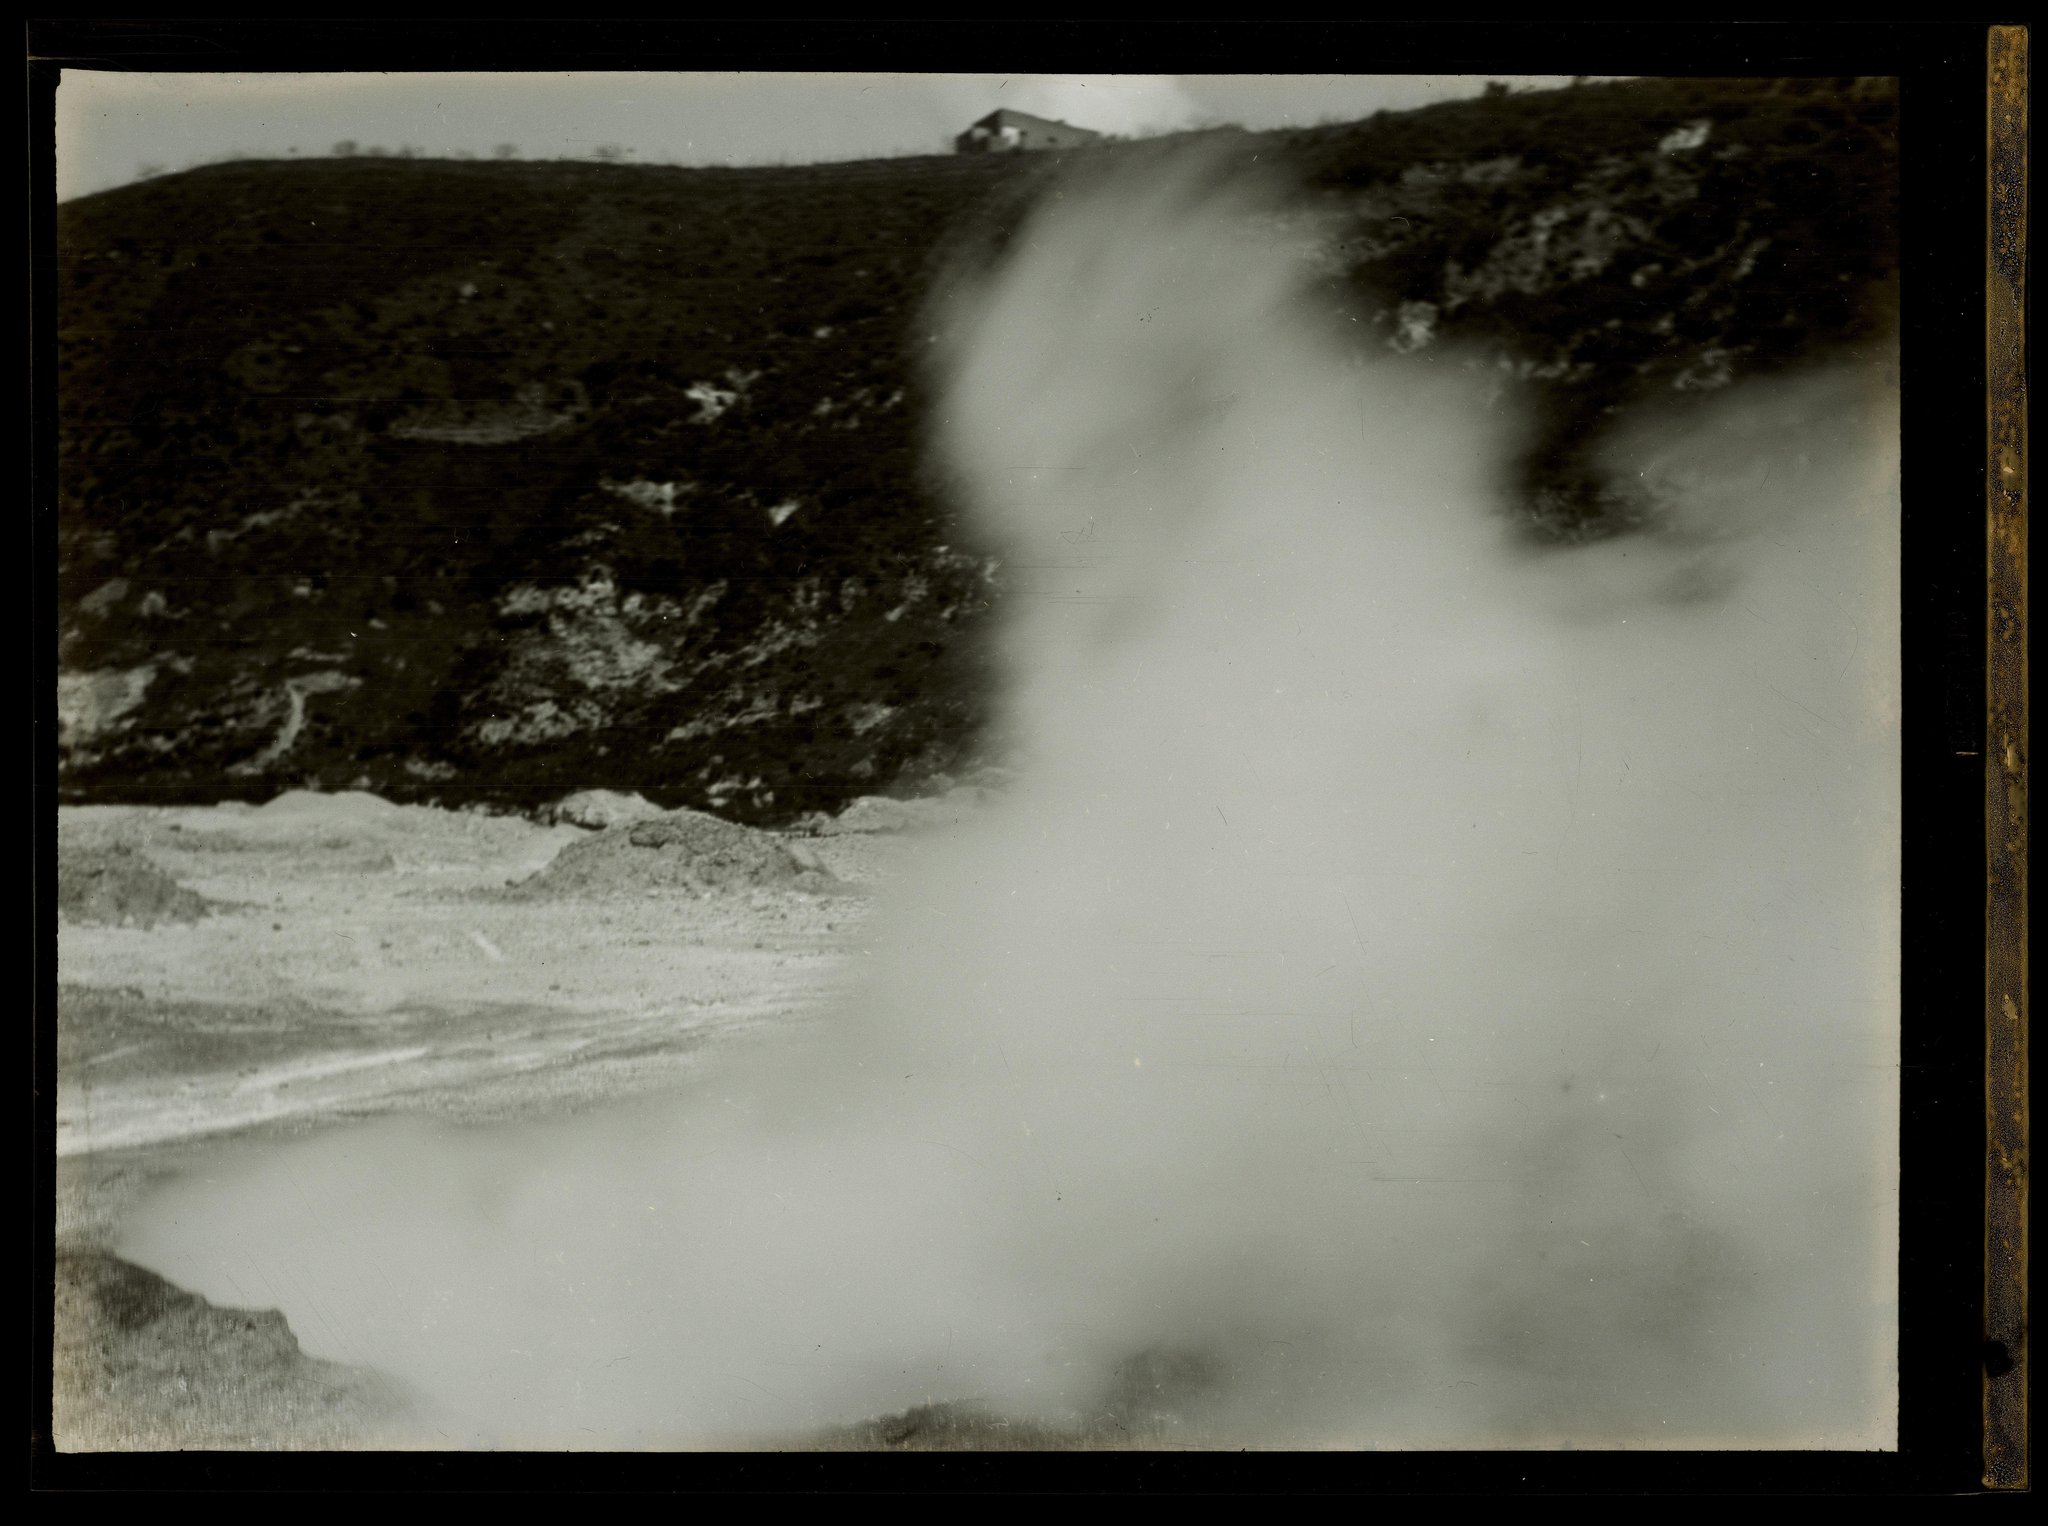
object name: photograph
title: Filmnegatief met opname van Napels of omgeving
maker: Anonymous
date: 1907-1935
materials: film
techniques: gelatin silver negative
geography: italy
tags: italy